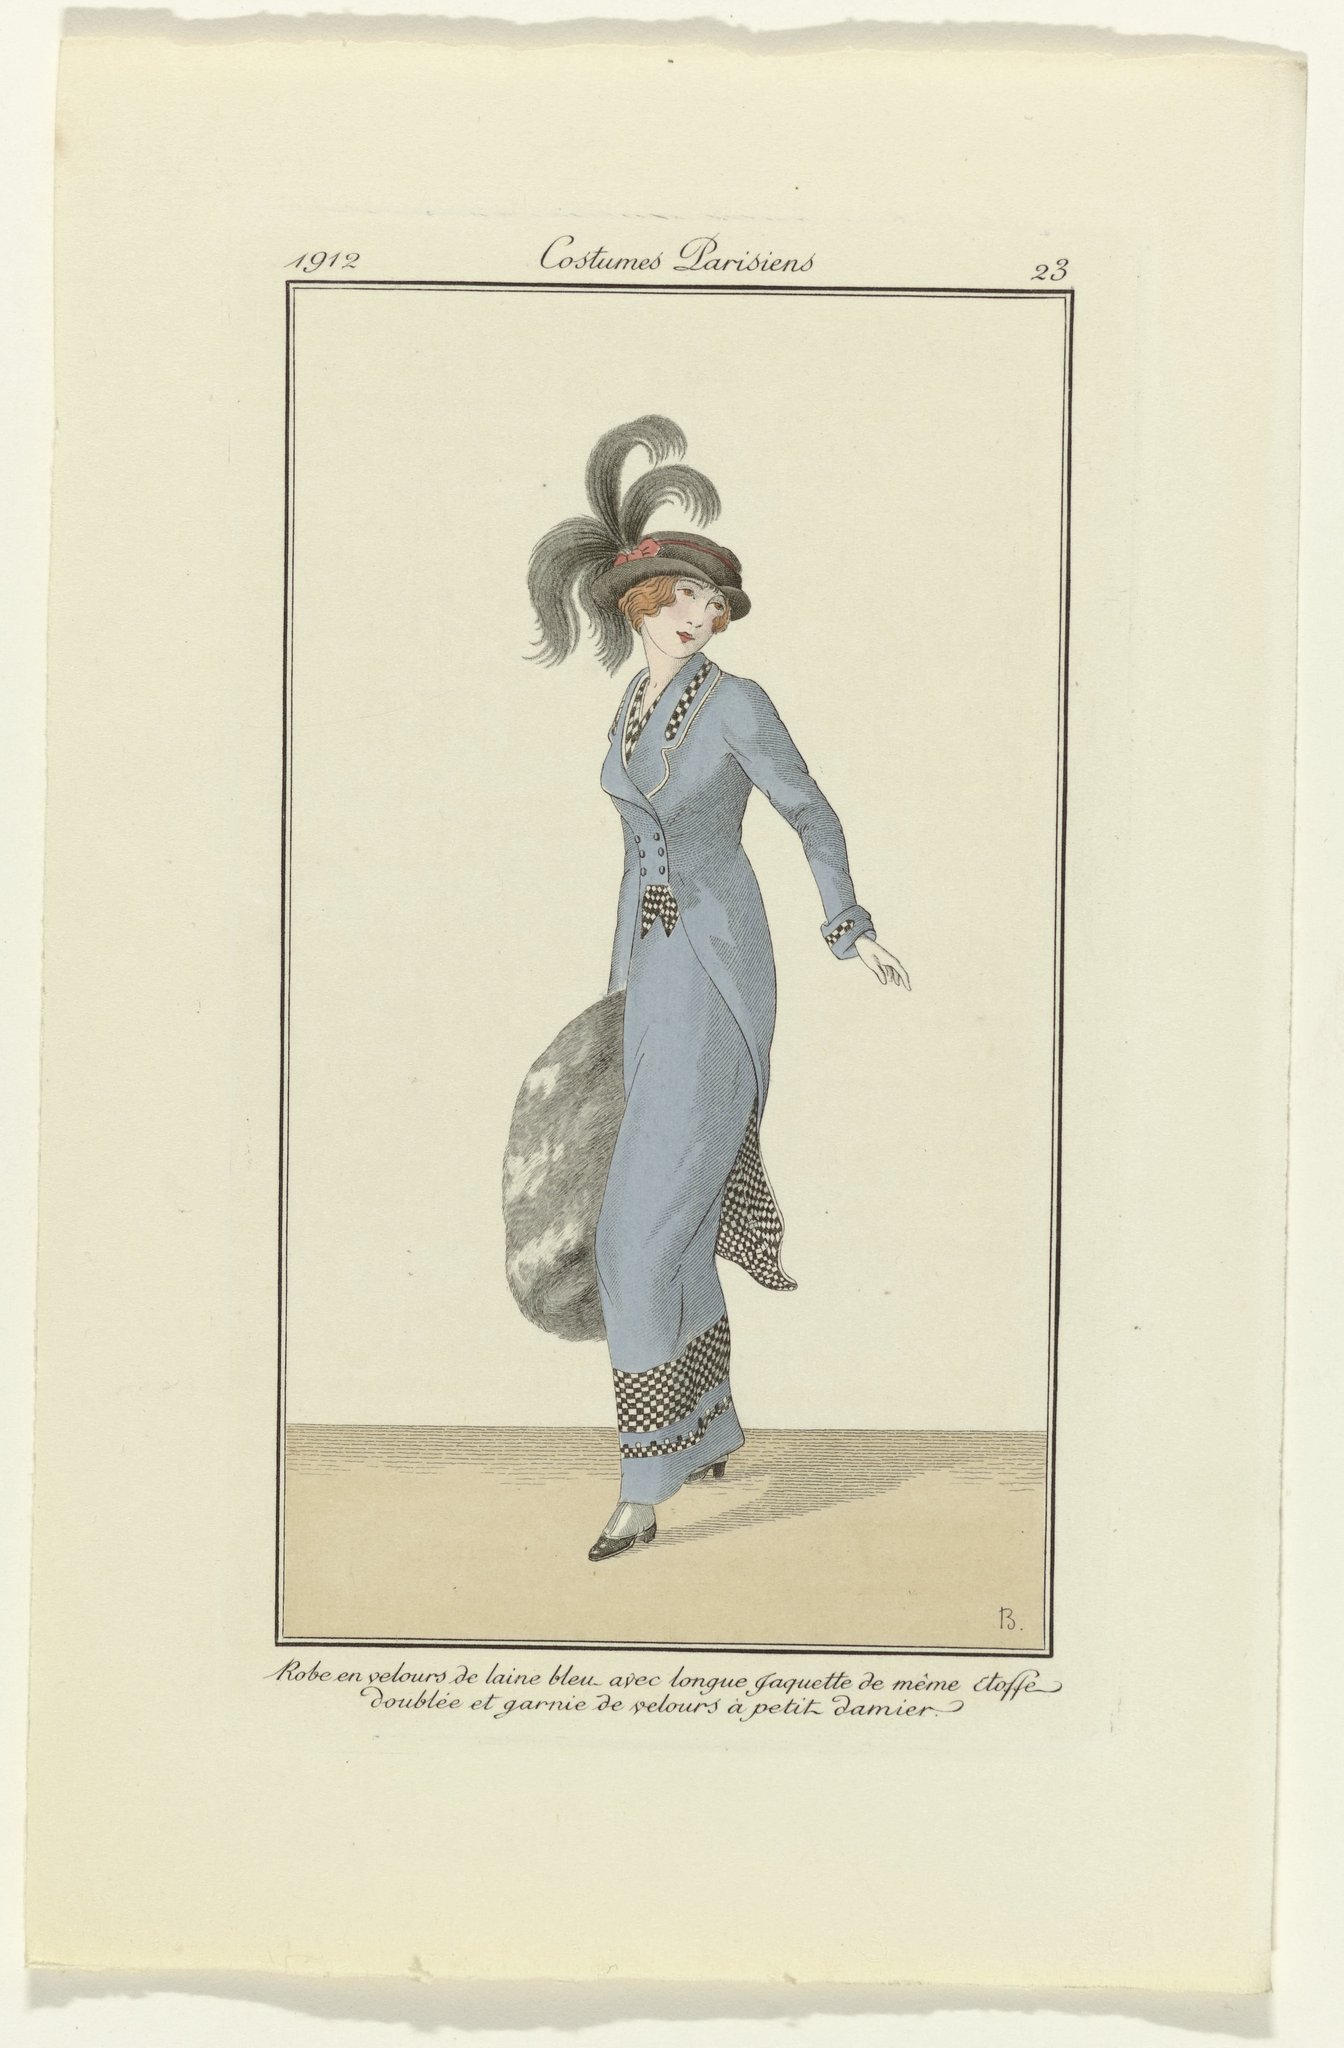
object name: fashion print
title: Journal des Dames et des Modes, 1912, Costumes Parisiens, no. 23: Robe en velours de laine bleu (...)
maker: Anonymous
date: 1912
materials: paper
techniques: engraving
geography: paris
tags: fashion plates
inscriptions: caption: ‘Robe de promenade en Sarah à damiers et taffetas peint à la main, bordée de velours noir: Chapeau de paille orné d'un panache en duvet de Cygne’